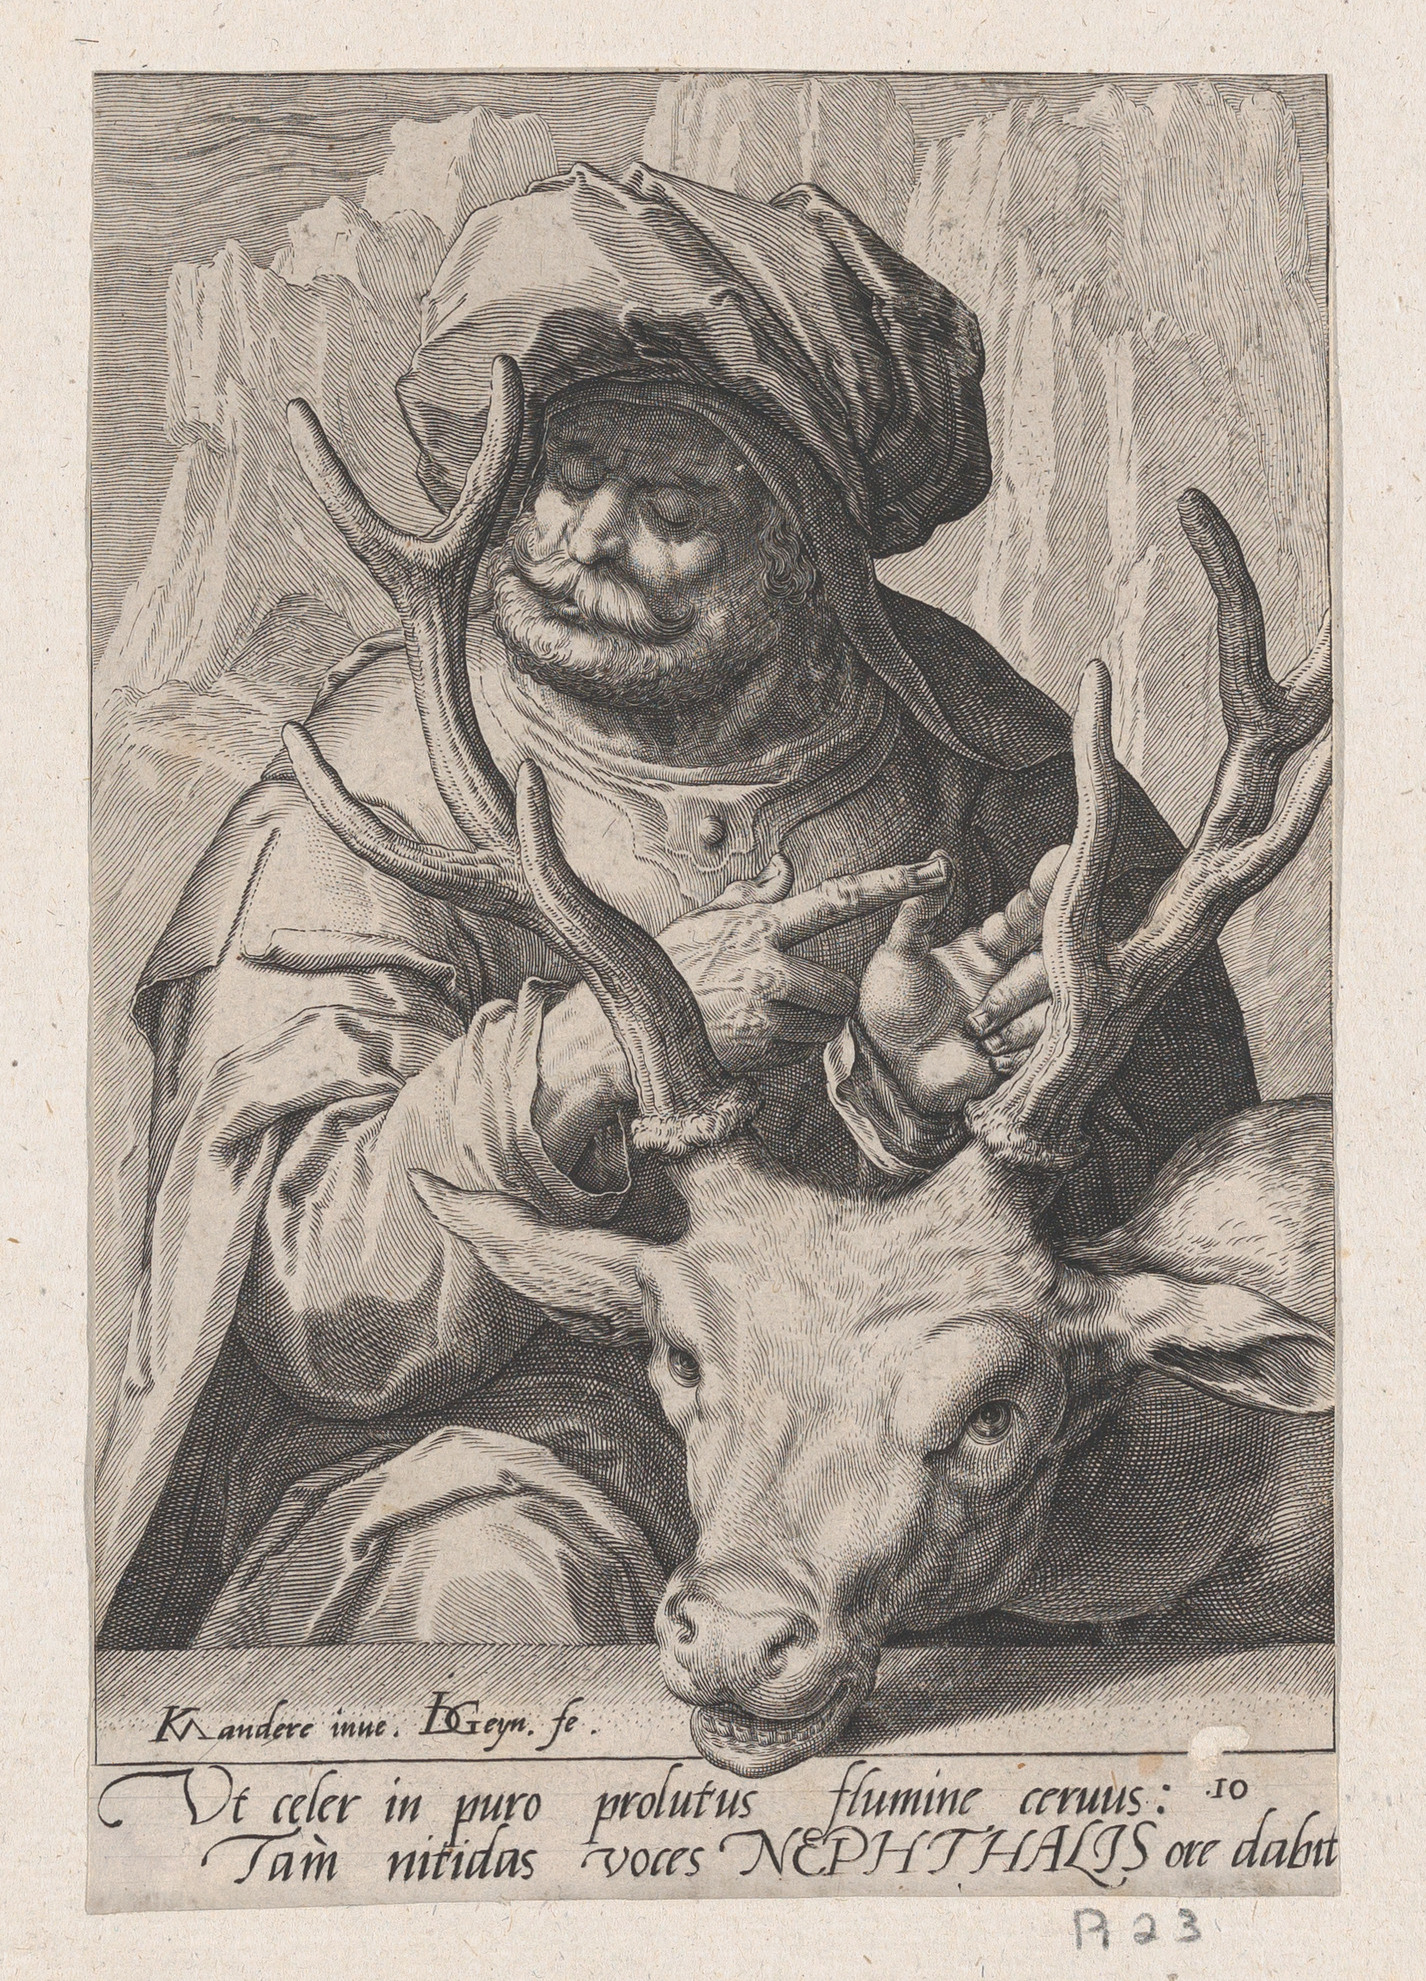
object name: print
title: Naphthali, from "The Twelve Sons of Jacob"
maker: jacques de gheyn (ii)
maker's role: artist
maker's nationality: netherlandish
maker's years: 1565-1629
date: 1584-1594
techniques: engraving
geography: amsterdam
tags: men,deer